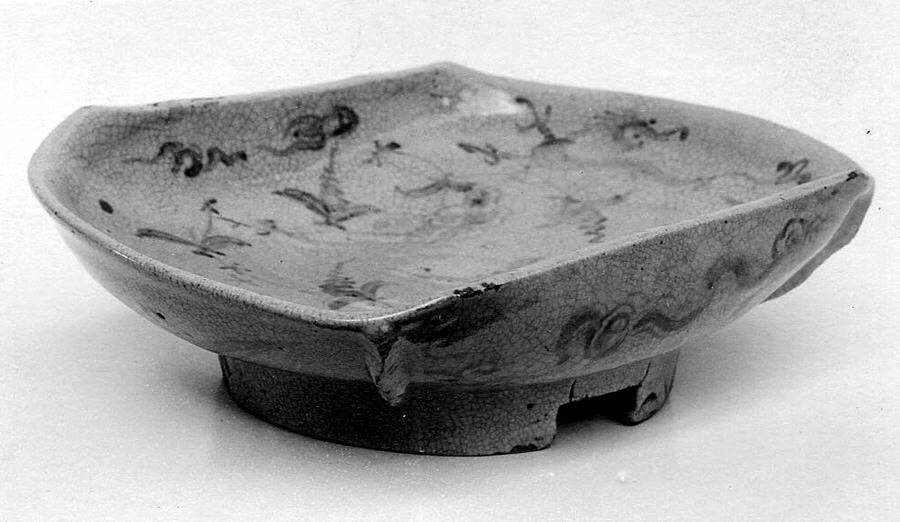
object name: cake dish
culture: japanese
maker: gempin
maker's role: artist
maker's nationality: chinese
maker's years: 1671-1771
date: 1645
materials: clay, glaze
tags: birds